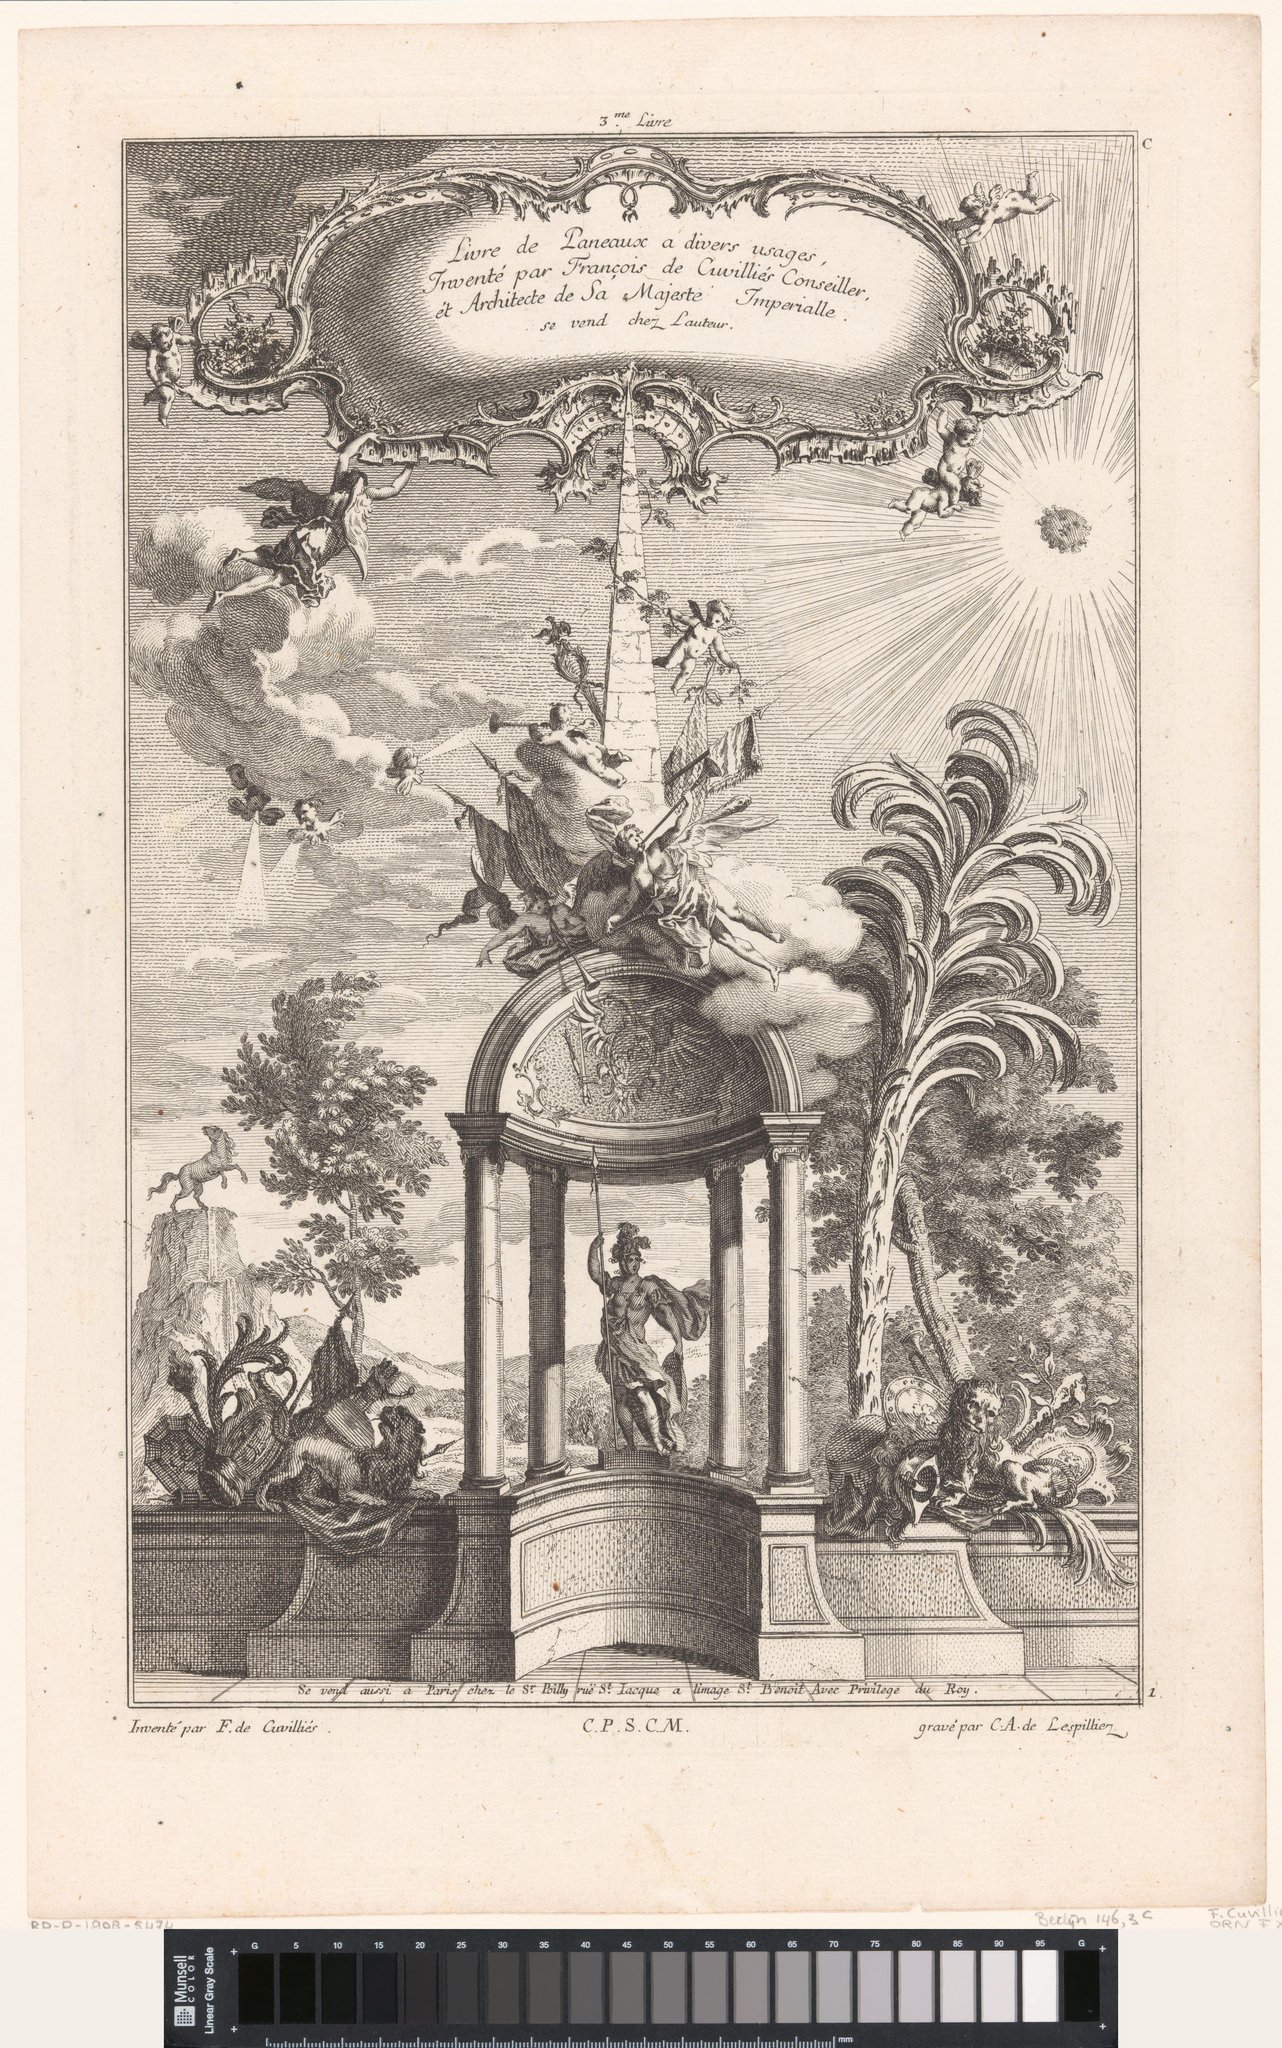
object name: titelprent, frontispice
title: Panelen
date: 1745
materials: paper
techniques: etching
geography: germany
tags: standing figure, other architectural details (cupola), armour, weapons, cupids: 'amores', 'amoretti', 'putti', angels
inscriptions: collector's mark: Lugt 2228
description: Onder een halve koepel staat een beeld van een staande man in harnas, aan weerszijden leeuwen en wapens. Boven de koepel een obelisk omgeven door engelen en putti blazend op bazuinen. Aan de bovenzijde een rocaille omlijsting met de serietitel, vastgehouden door een engel en putti.